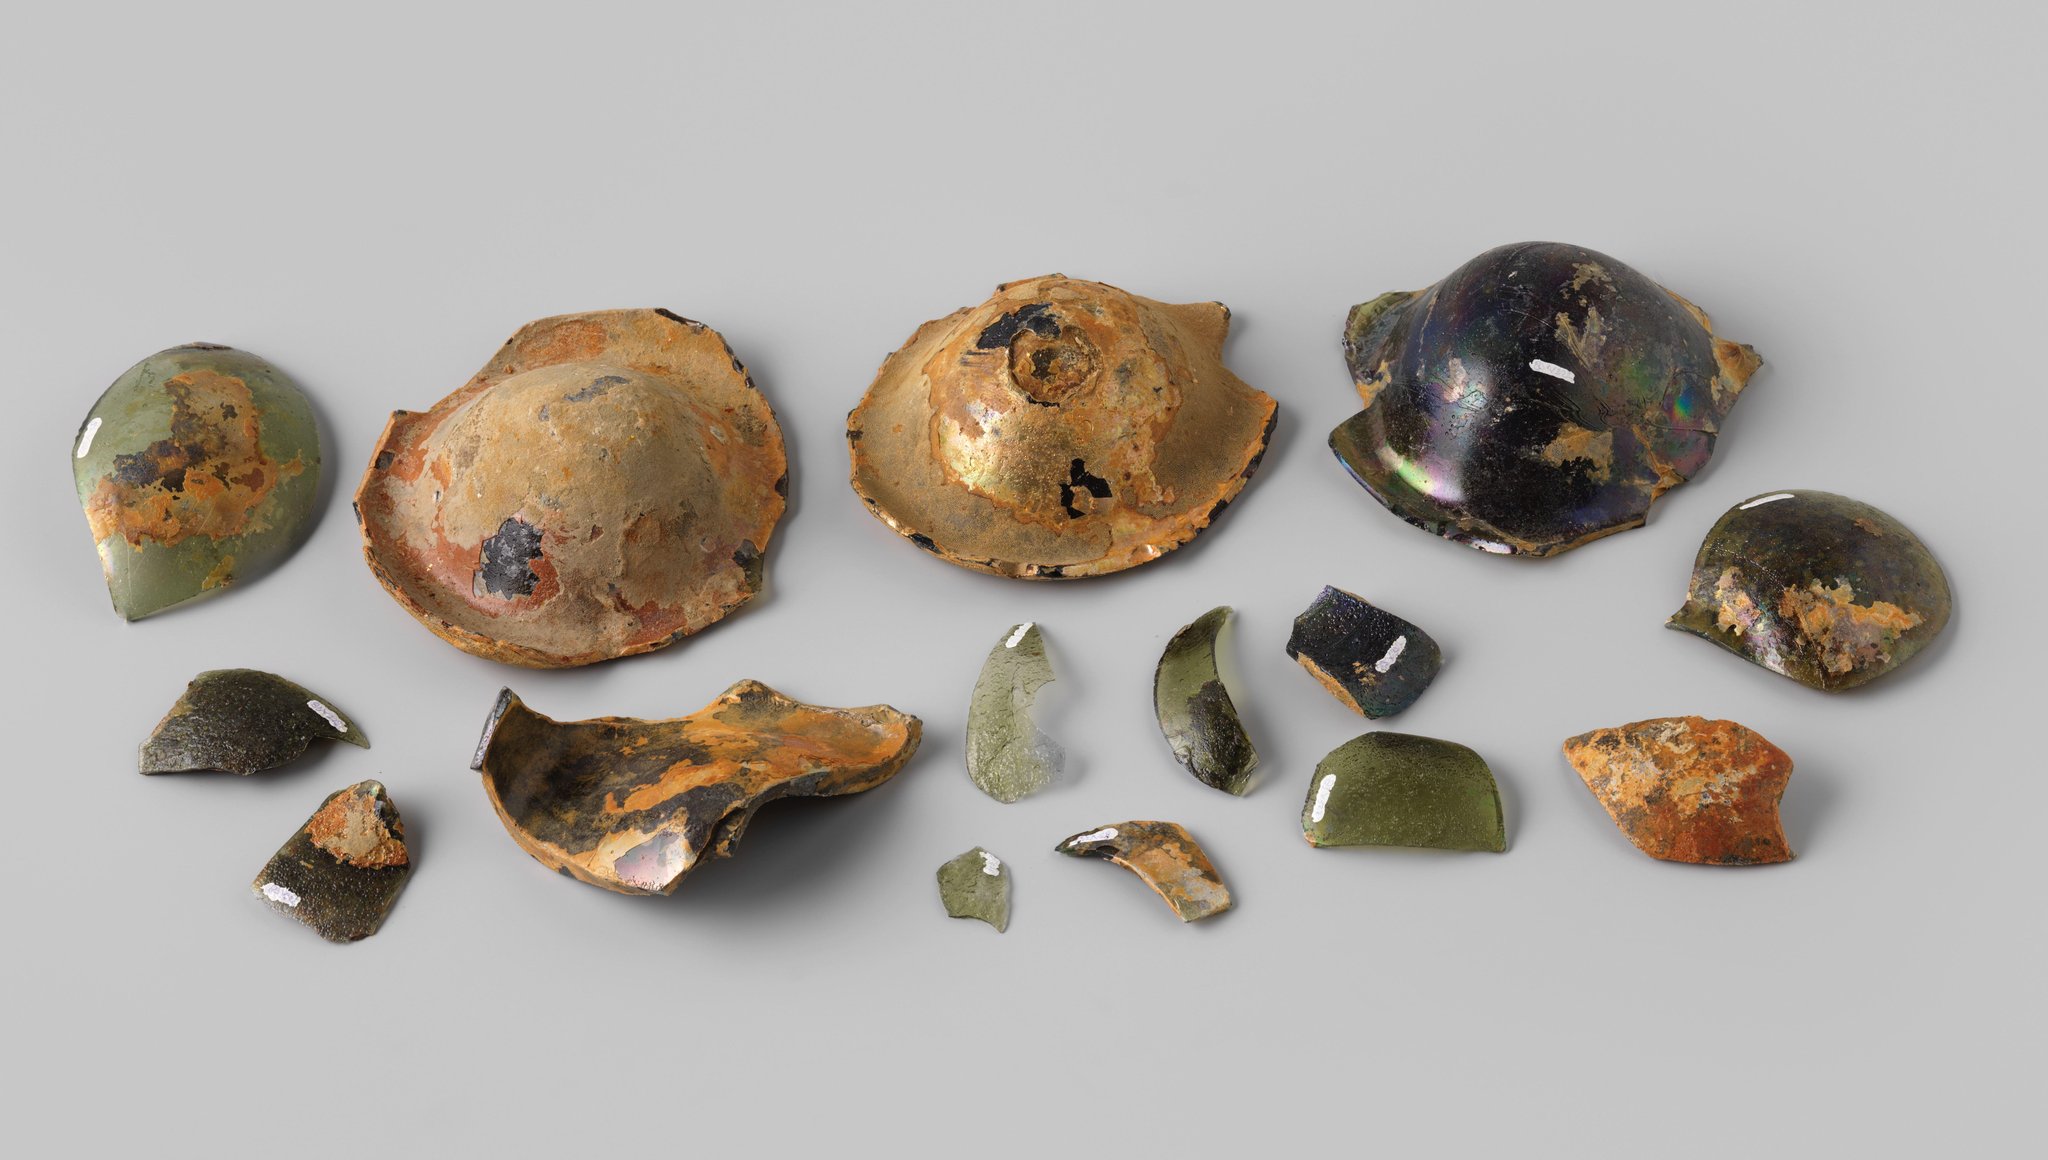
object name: sherd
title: Scherven van wijnflessen uit het wrak van de Oost-Indiëvaarder 't Vliegend Hart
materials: glass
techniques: green glass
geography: netherlands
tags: 't vliegend hart (schip), verenigde oostindische compagnie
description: Scherven van uivormige wijnflessen van groen glas waar rode (port)wijn in heeft gezeten.